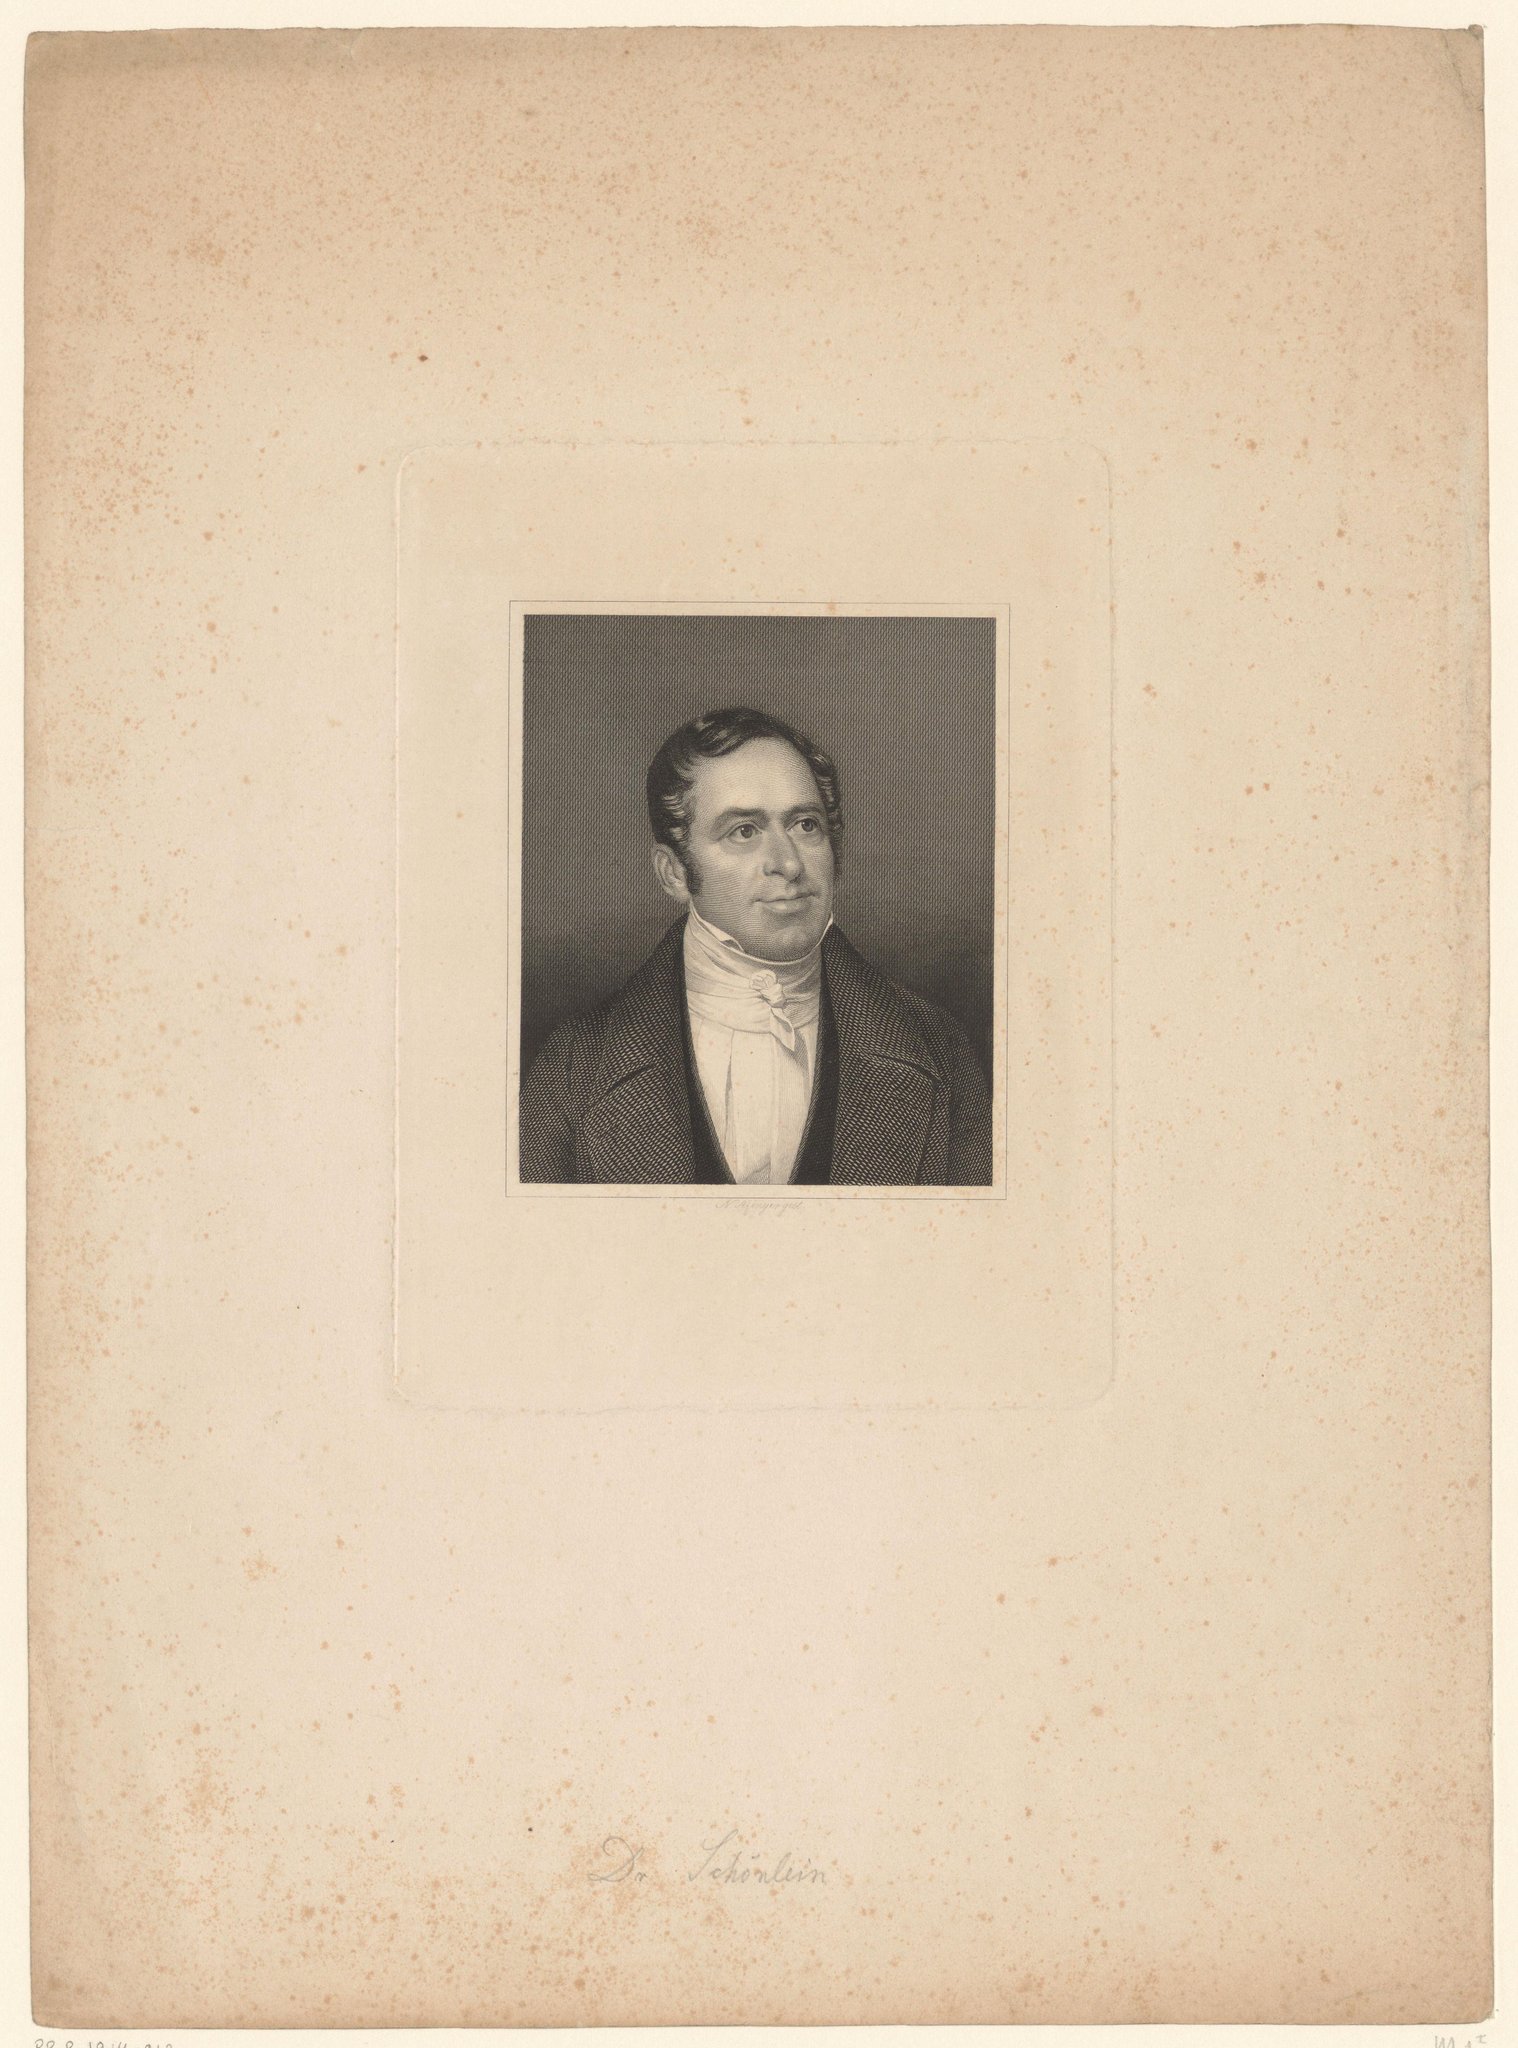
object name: print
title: Portret van Johann Lukas Schönlein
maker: nikolaus afinger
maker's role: print maker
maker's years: 1818-1852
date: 1828-1852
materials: paper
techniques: etching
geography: germany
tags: historical persons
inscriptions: collector's mark: Lugt 2228